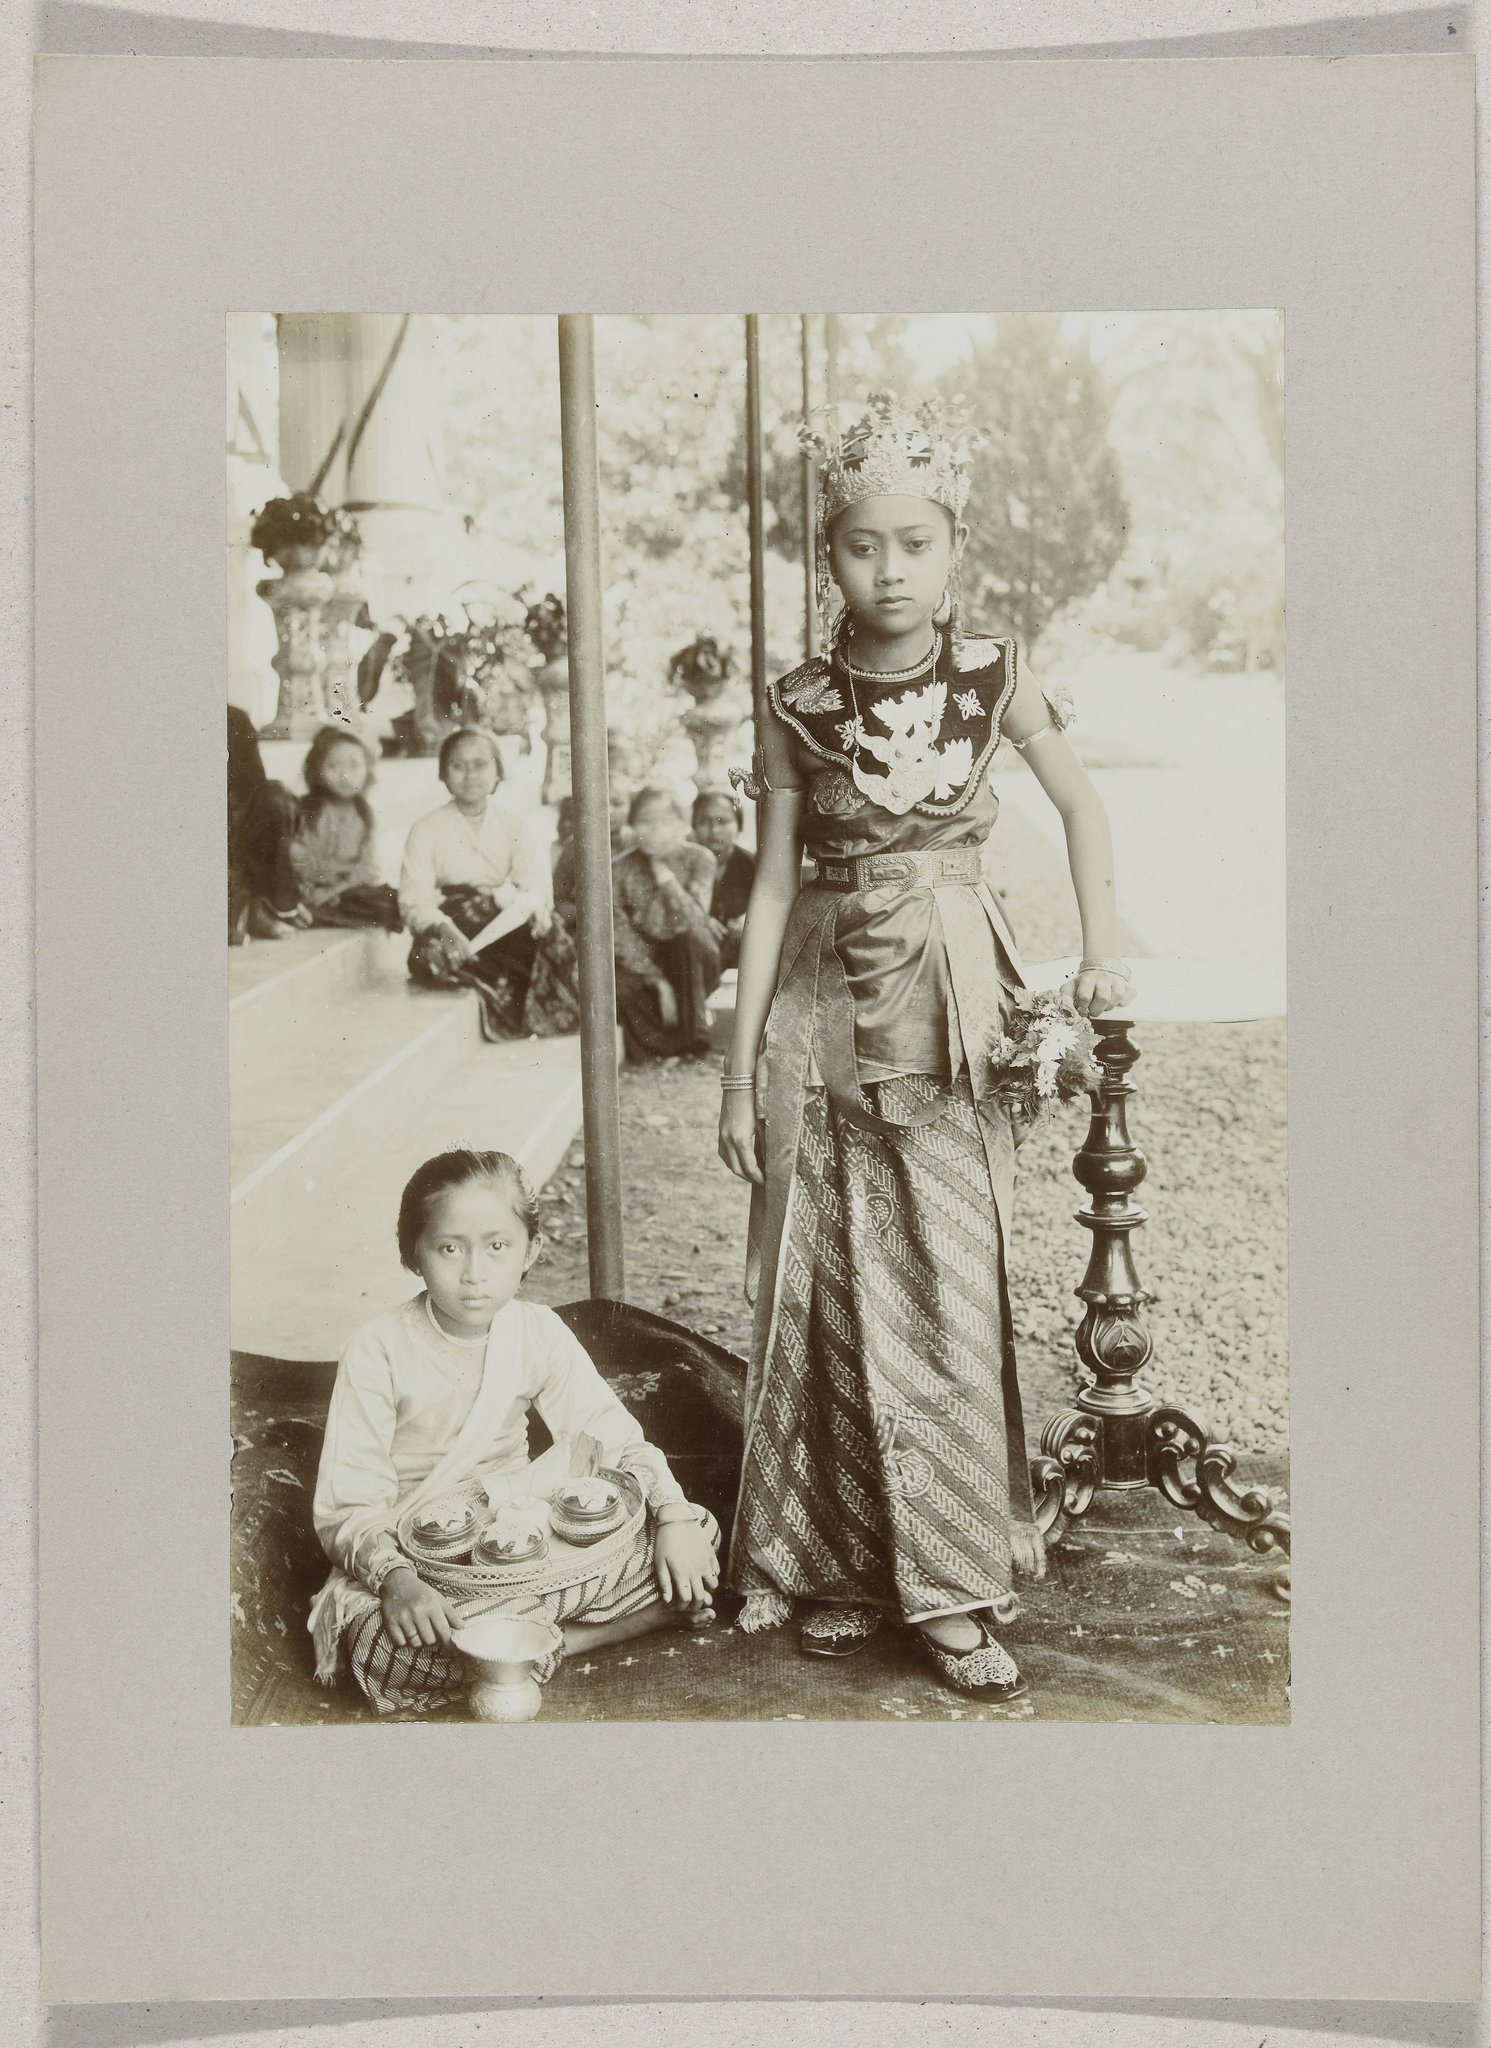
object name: photograph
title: Portret van een meisje, in feestelijke kledij in Nederlands-Indië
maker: Anonymous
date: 1895-1915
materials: cardboard, paper, photographic support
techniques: gelatin silver print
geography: dutch east indies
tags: indonesia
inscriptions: number: ‘38’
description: Portret van een meisje, in feestelijke kledij, Nederlands-Indië